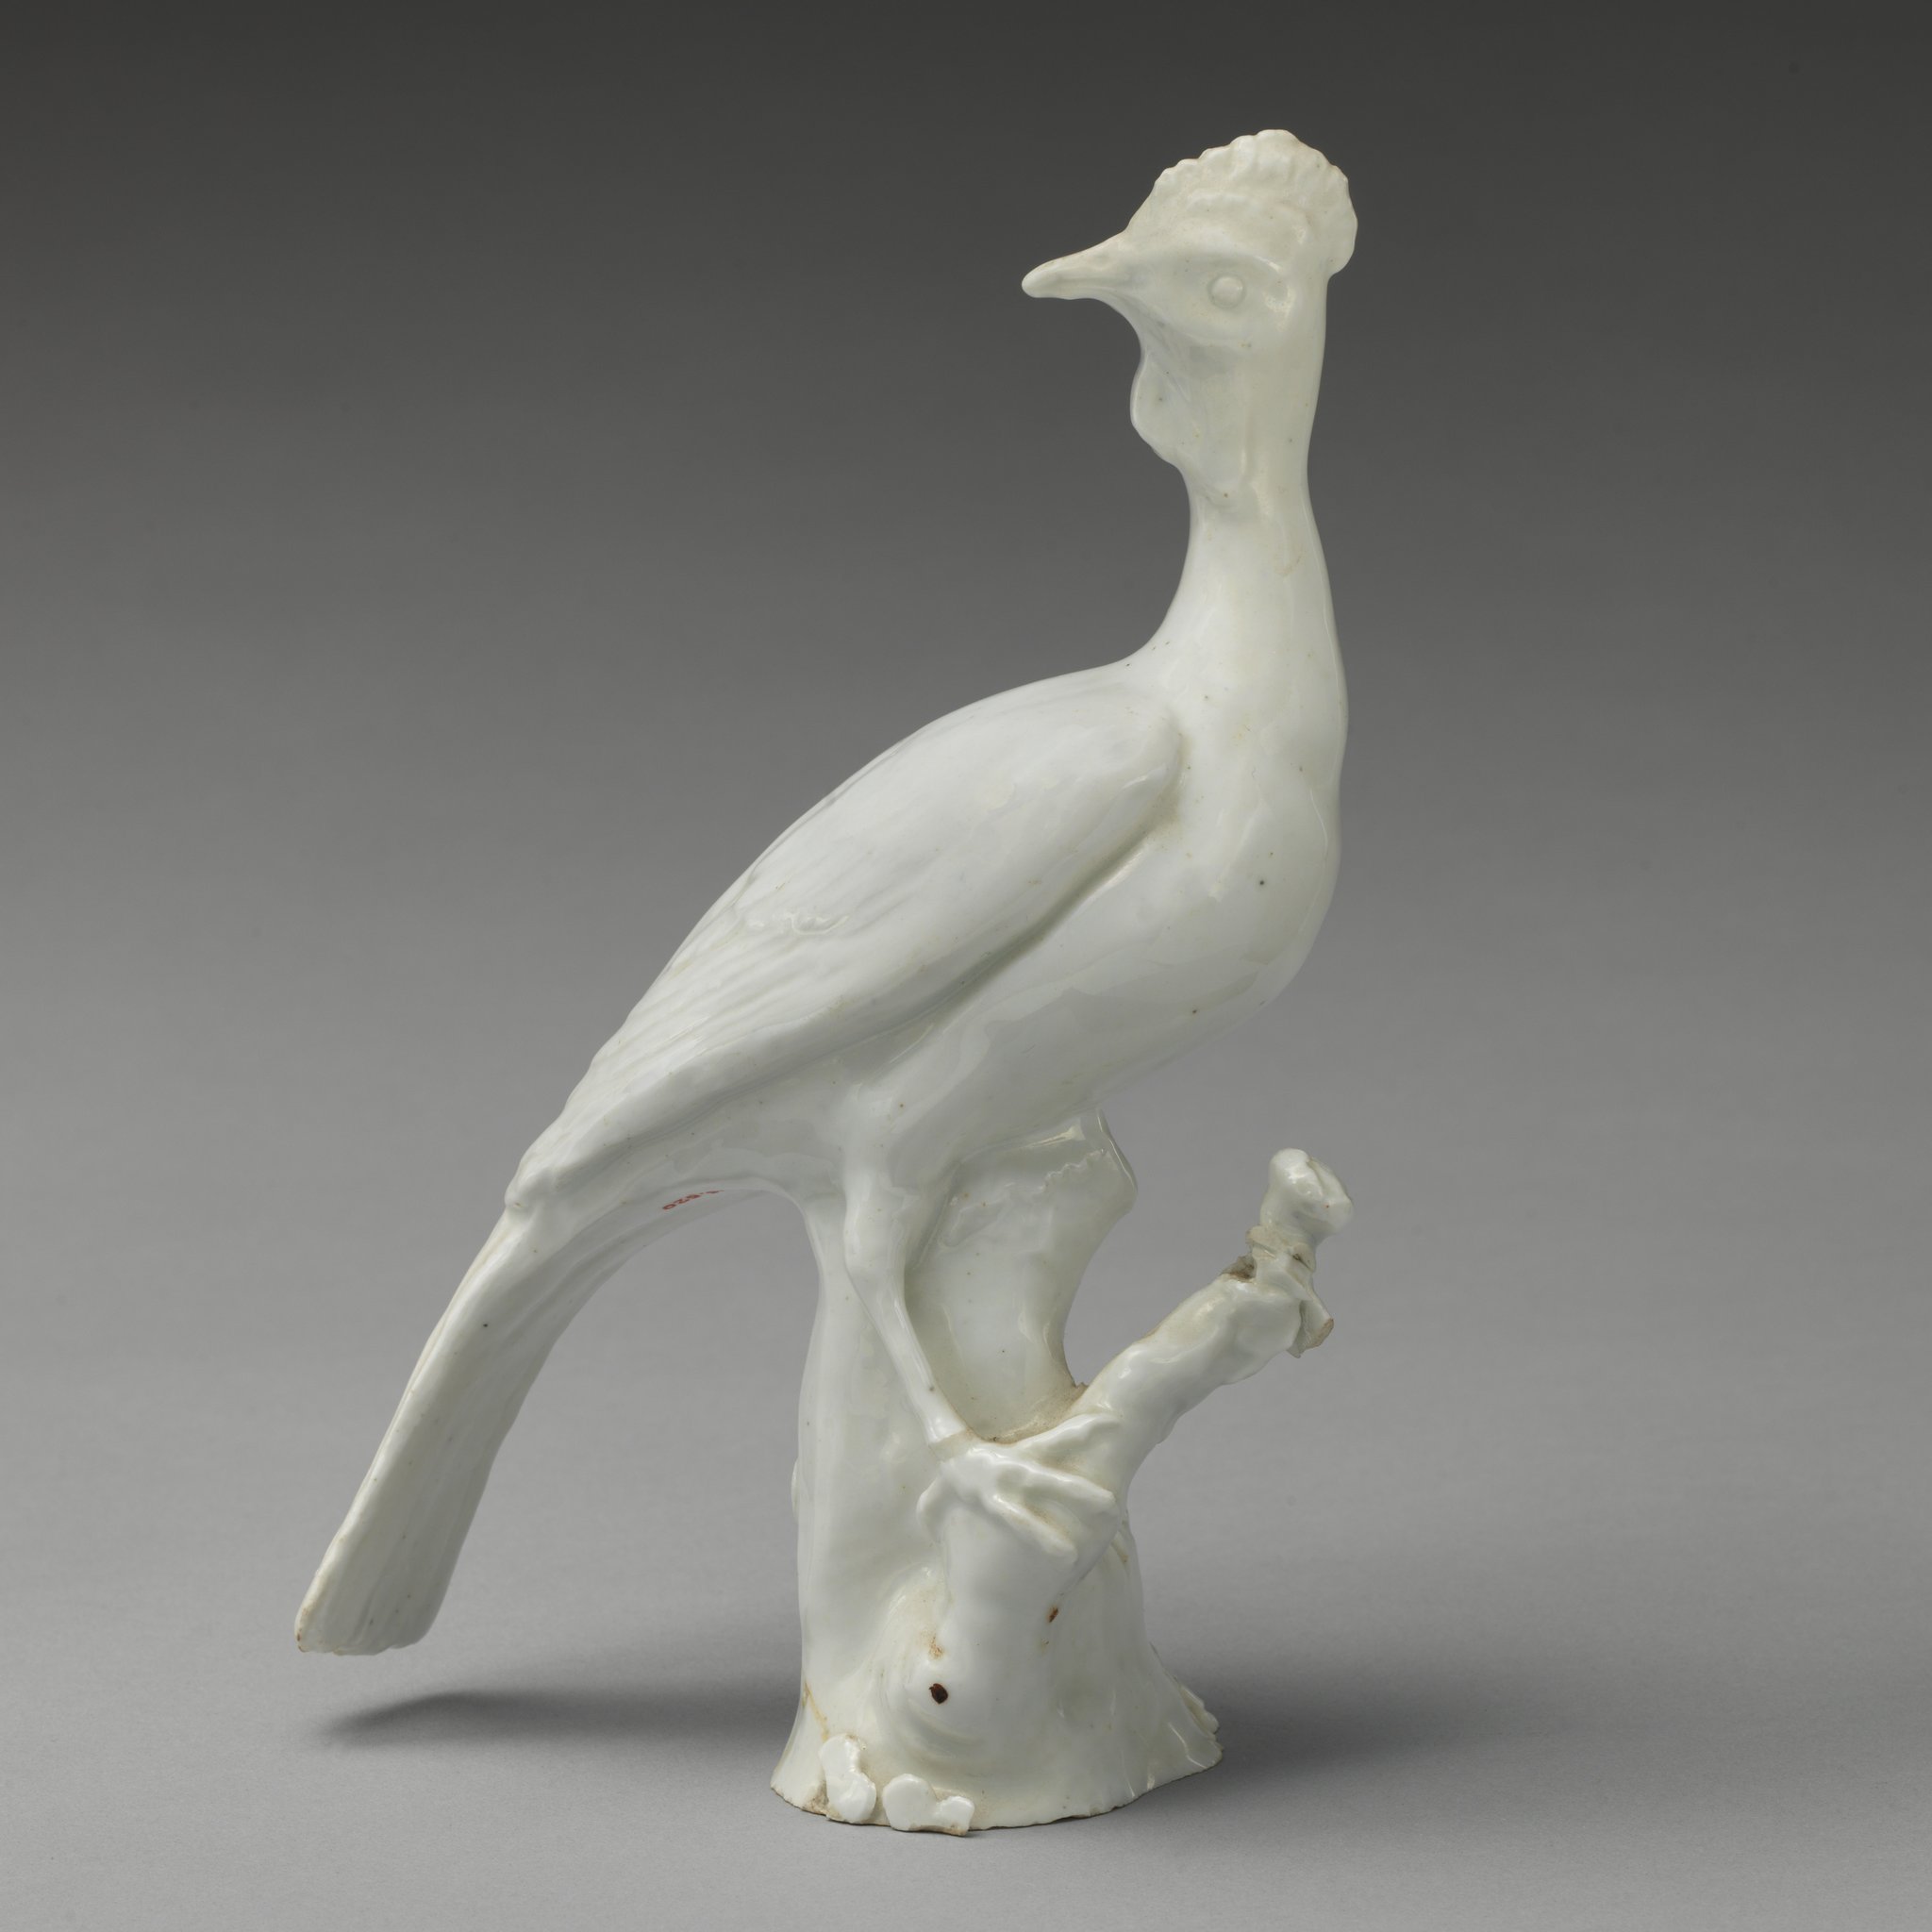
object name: figure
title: Bird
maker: chelsea porcelain manufactory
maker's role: factory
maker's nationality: british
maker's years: 1744-1784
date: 1752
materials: soft paste porcelain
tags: birds